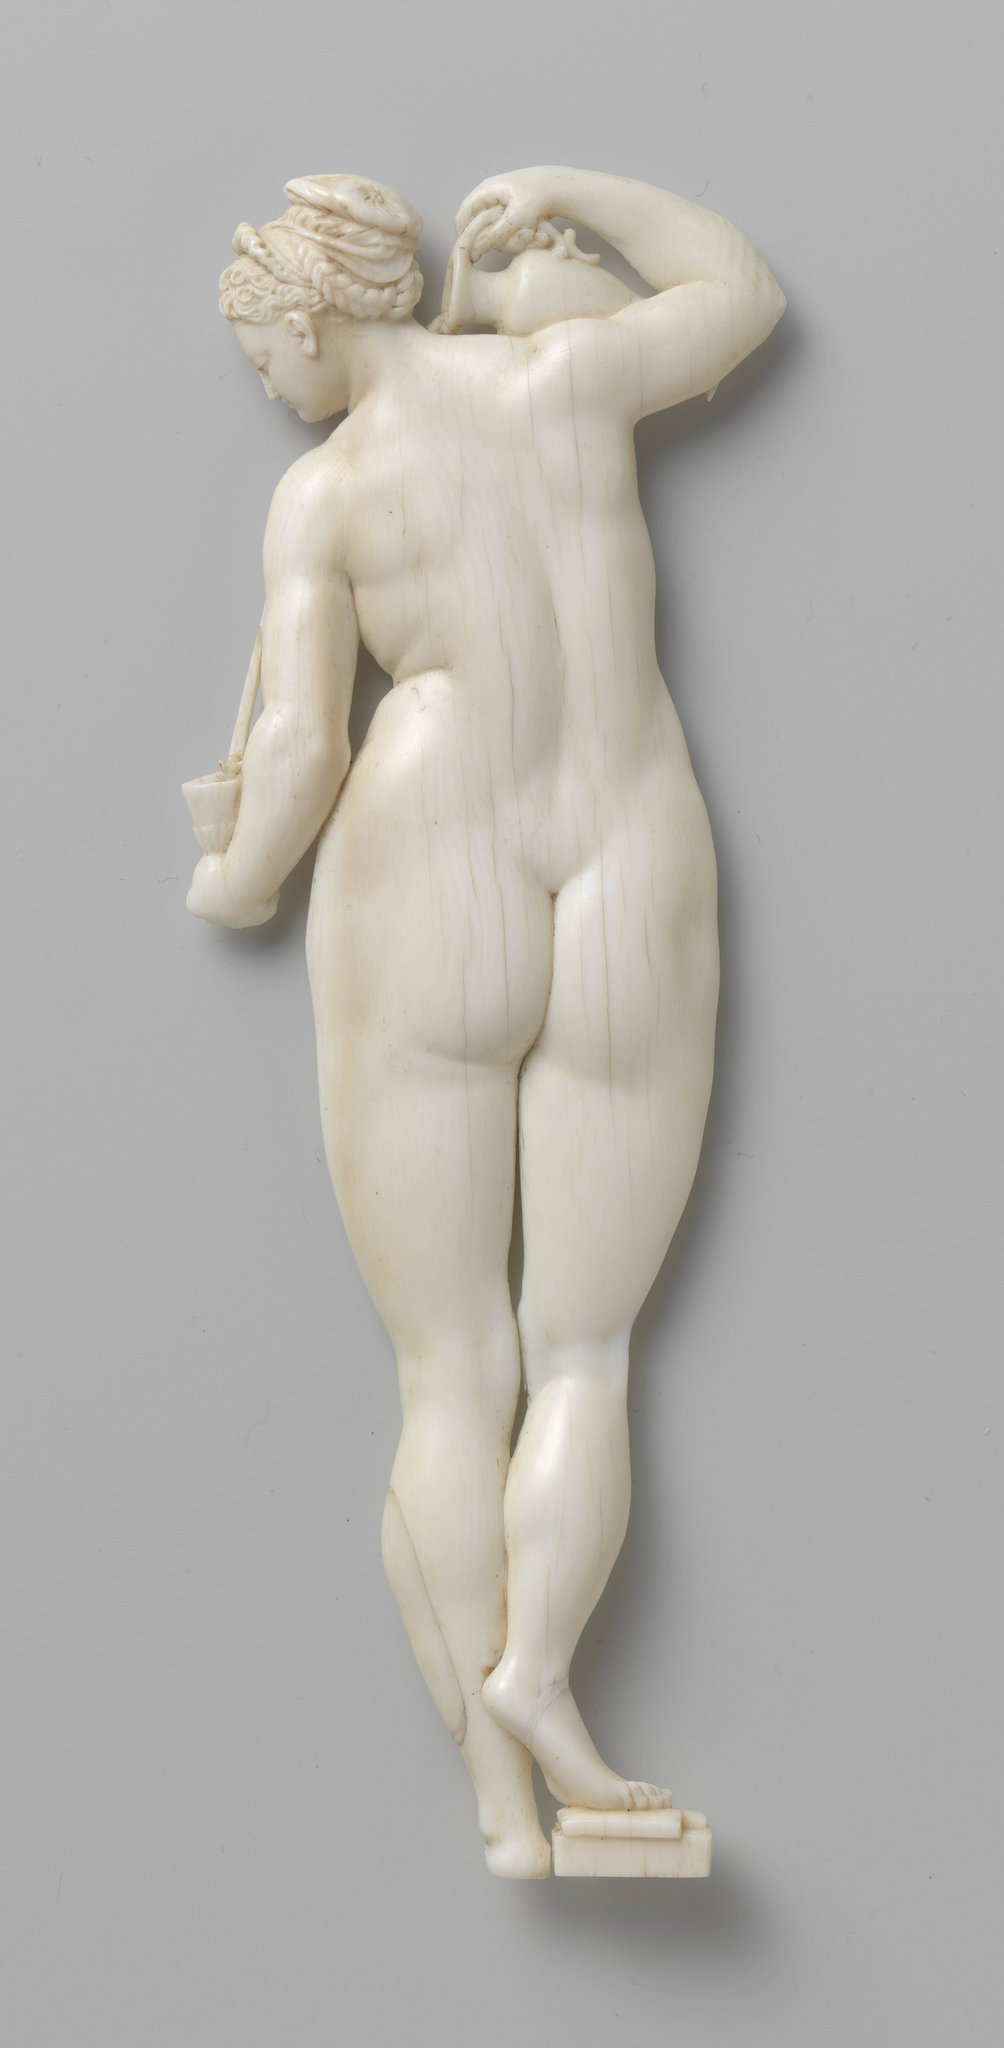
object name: figure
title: Temperantia, rugfiguur van een naakte vrouw met schenkkan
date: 1600-1625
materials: ivory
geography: southern germany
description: Temperance and Justice. Ivory. Southern Germany, c. 1600-1650. The figure of Temperance was taken from an engraving by Hendrick Goltzius (1558-1617). Justice is based on her: although reversed, the contour is virtually identical. Probably the figures were originally applied to a cabinet. Justice: gift of J. Holstein, 1994.